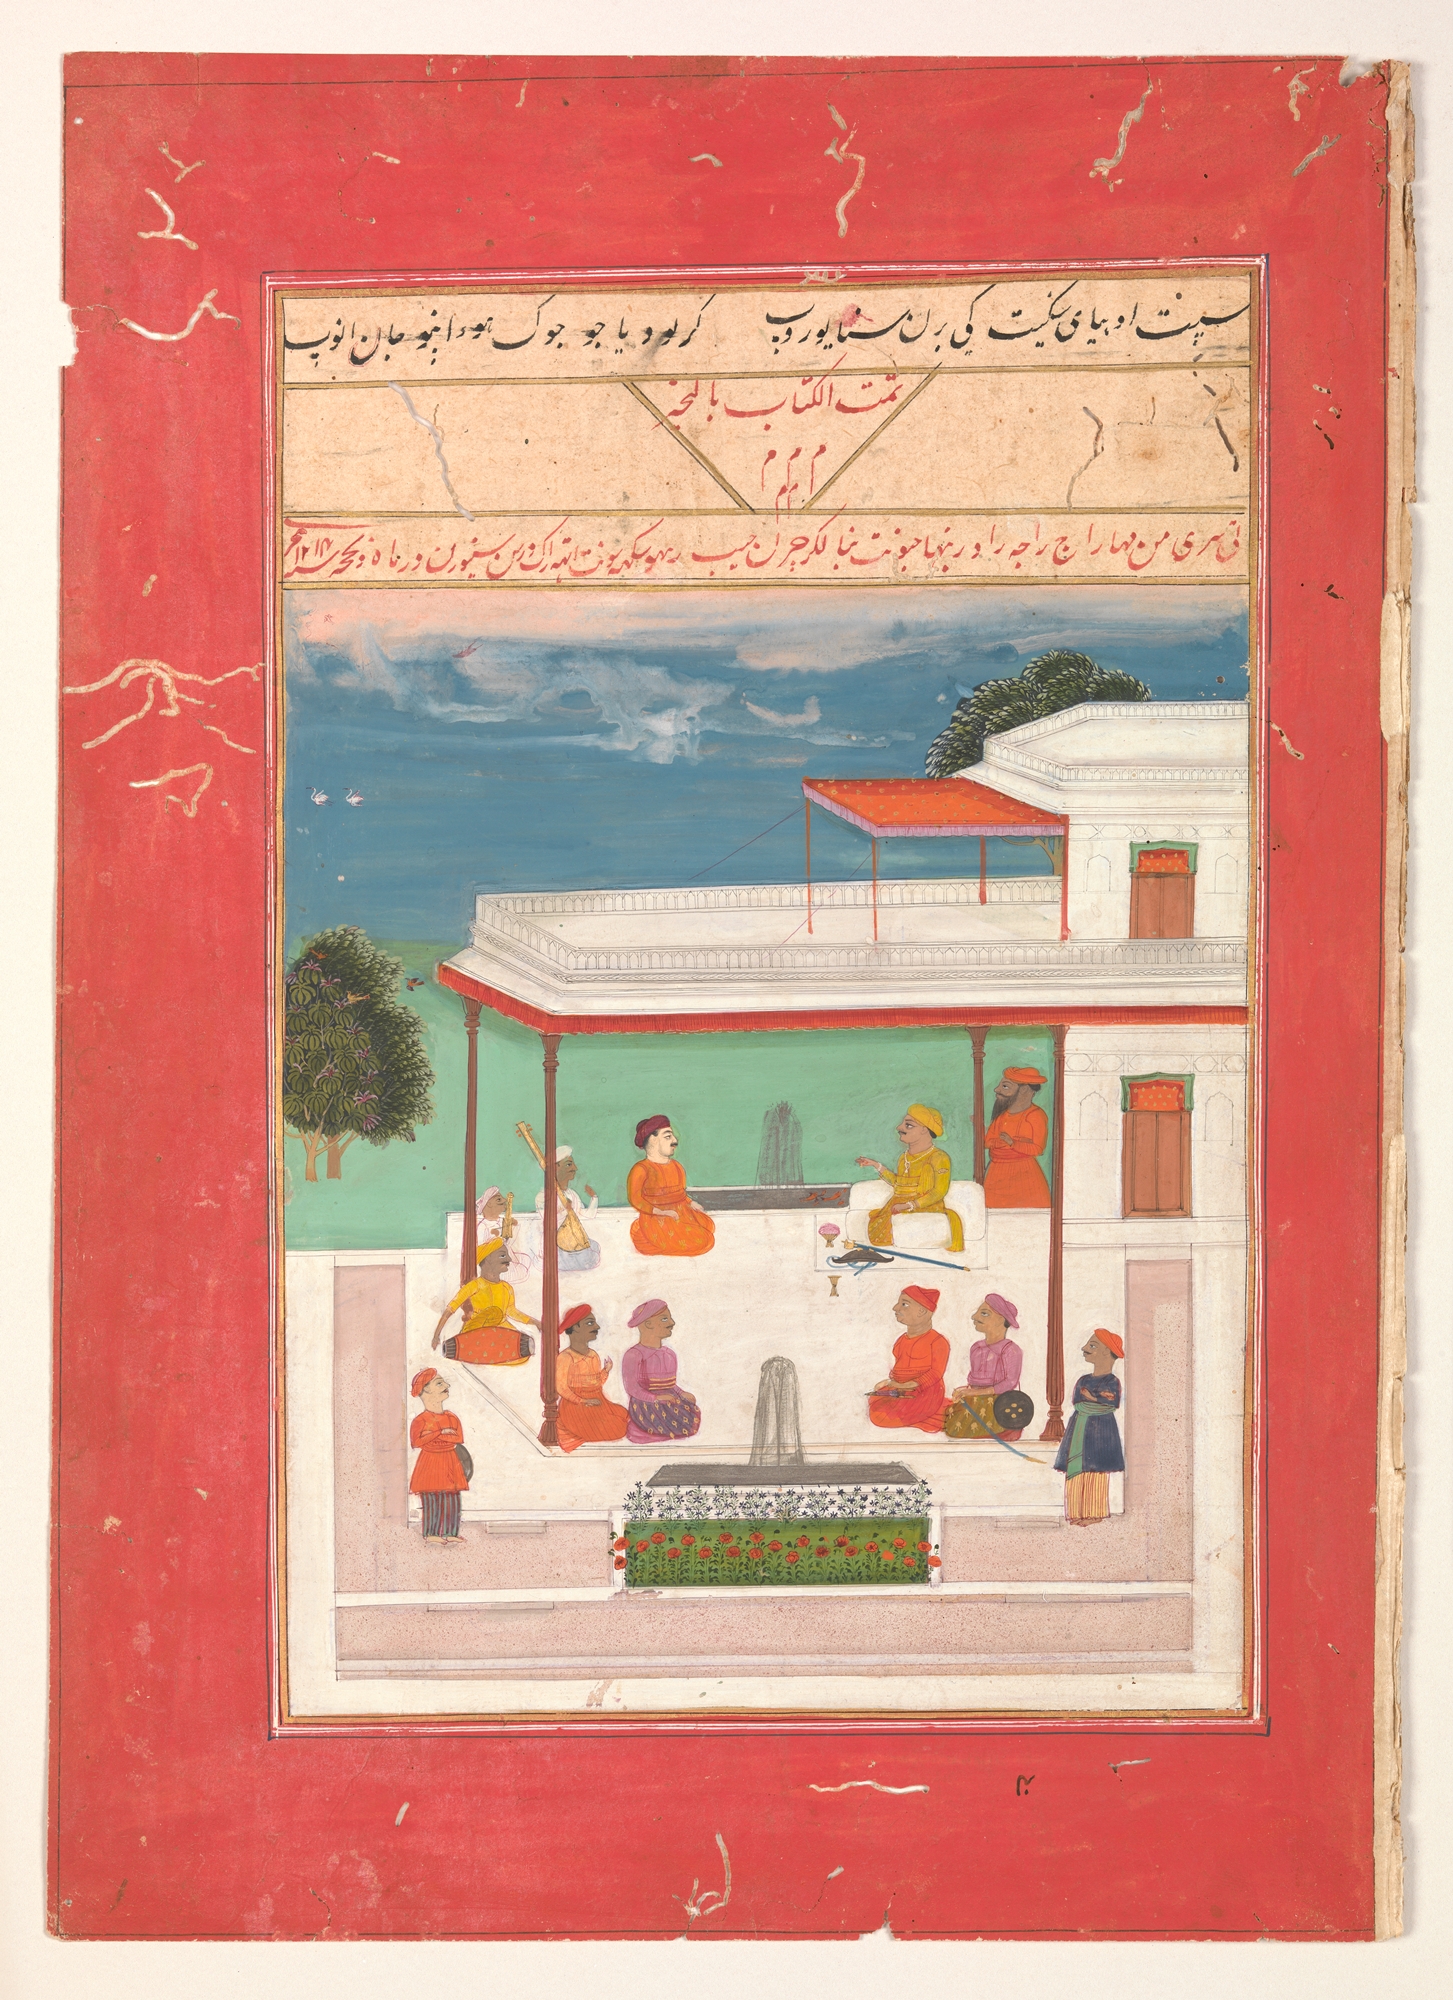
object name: folio from an illustrated manuscript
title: "A Raja and a Guest Seated on a Terrace Listening to Musicians Perform", Folio from a manuscript of the Raga Darshan of Anup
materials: paper, watercolor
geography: india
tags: kings,men,musicians